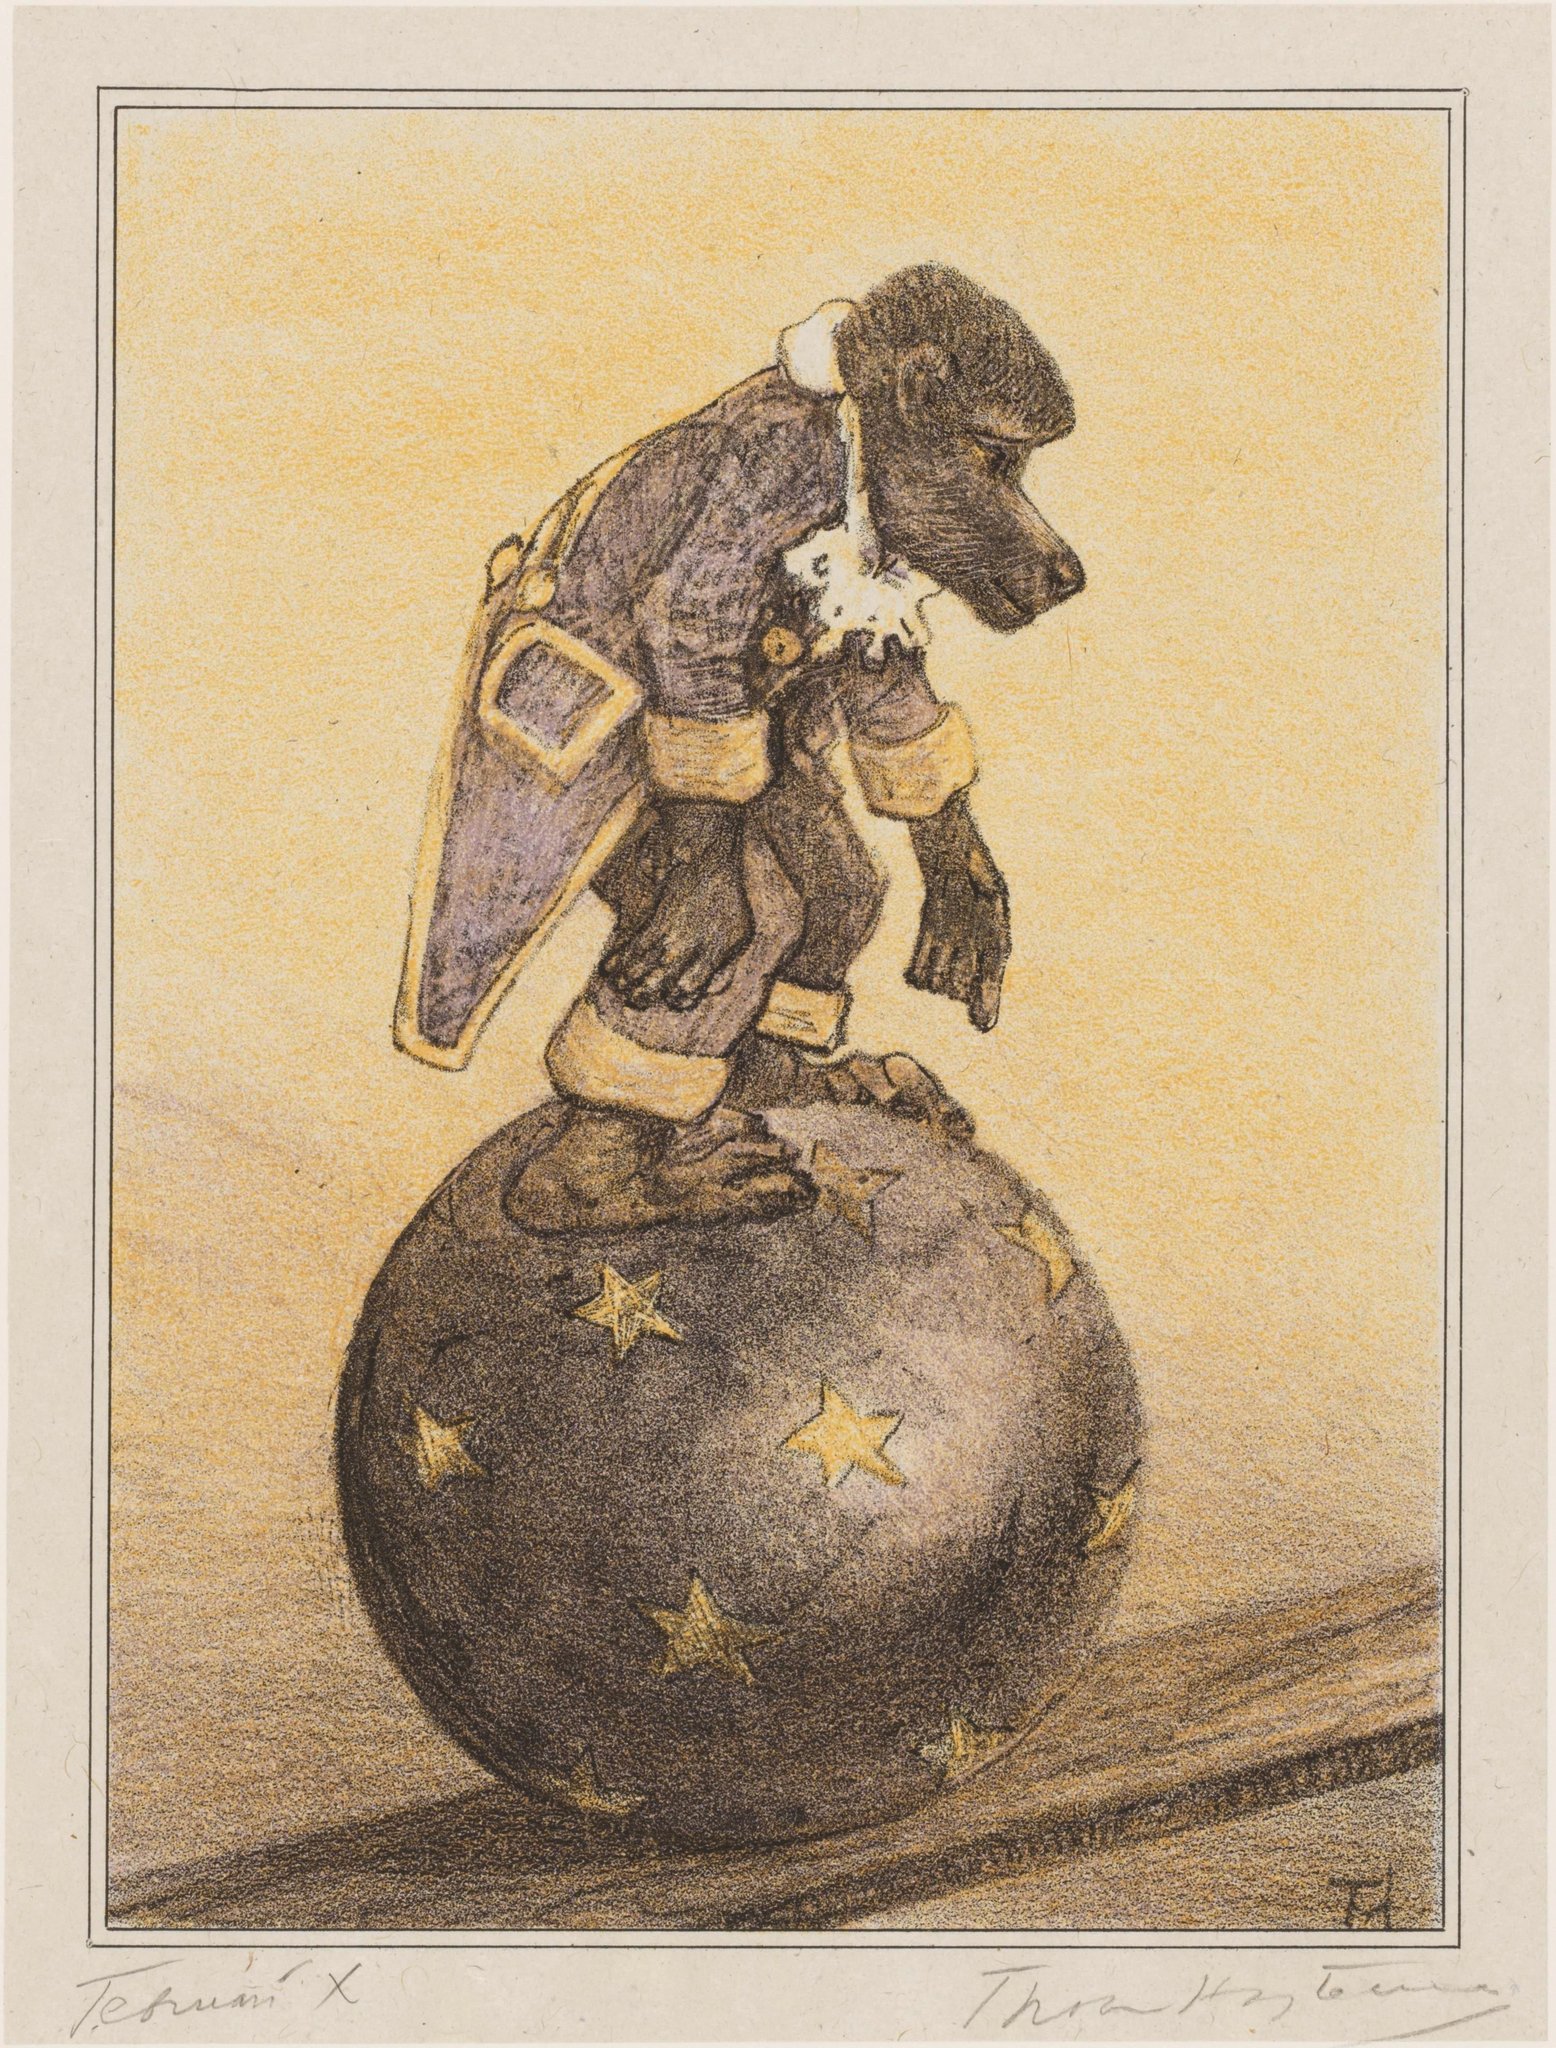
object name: print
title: Aap op bal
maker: theo van hoytema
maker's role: draughtsman, painter, print maker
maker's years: 1863-1917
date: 1878-1910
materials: paper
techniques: lithograph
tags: monkeys, apes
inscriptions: collector's mark: Lugt 2233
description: Prent is een proefdruk voor kalenderblad februari 1910.